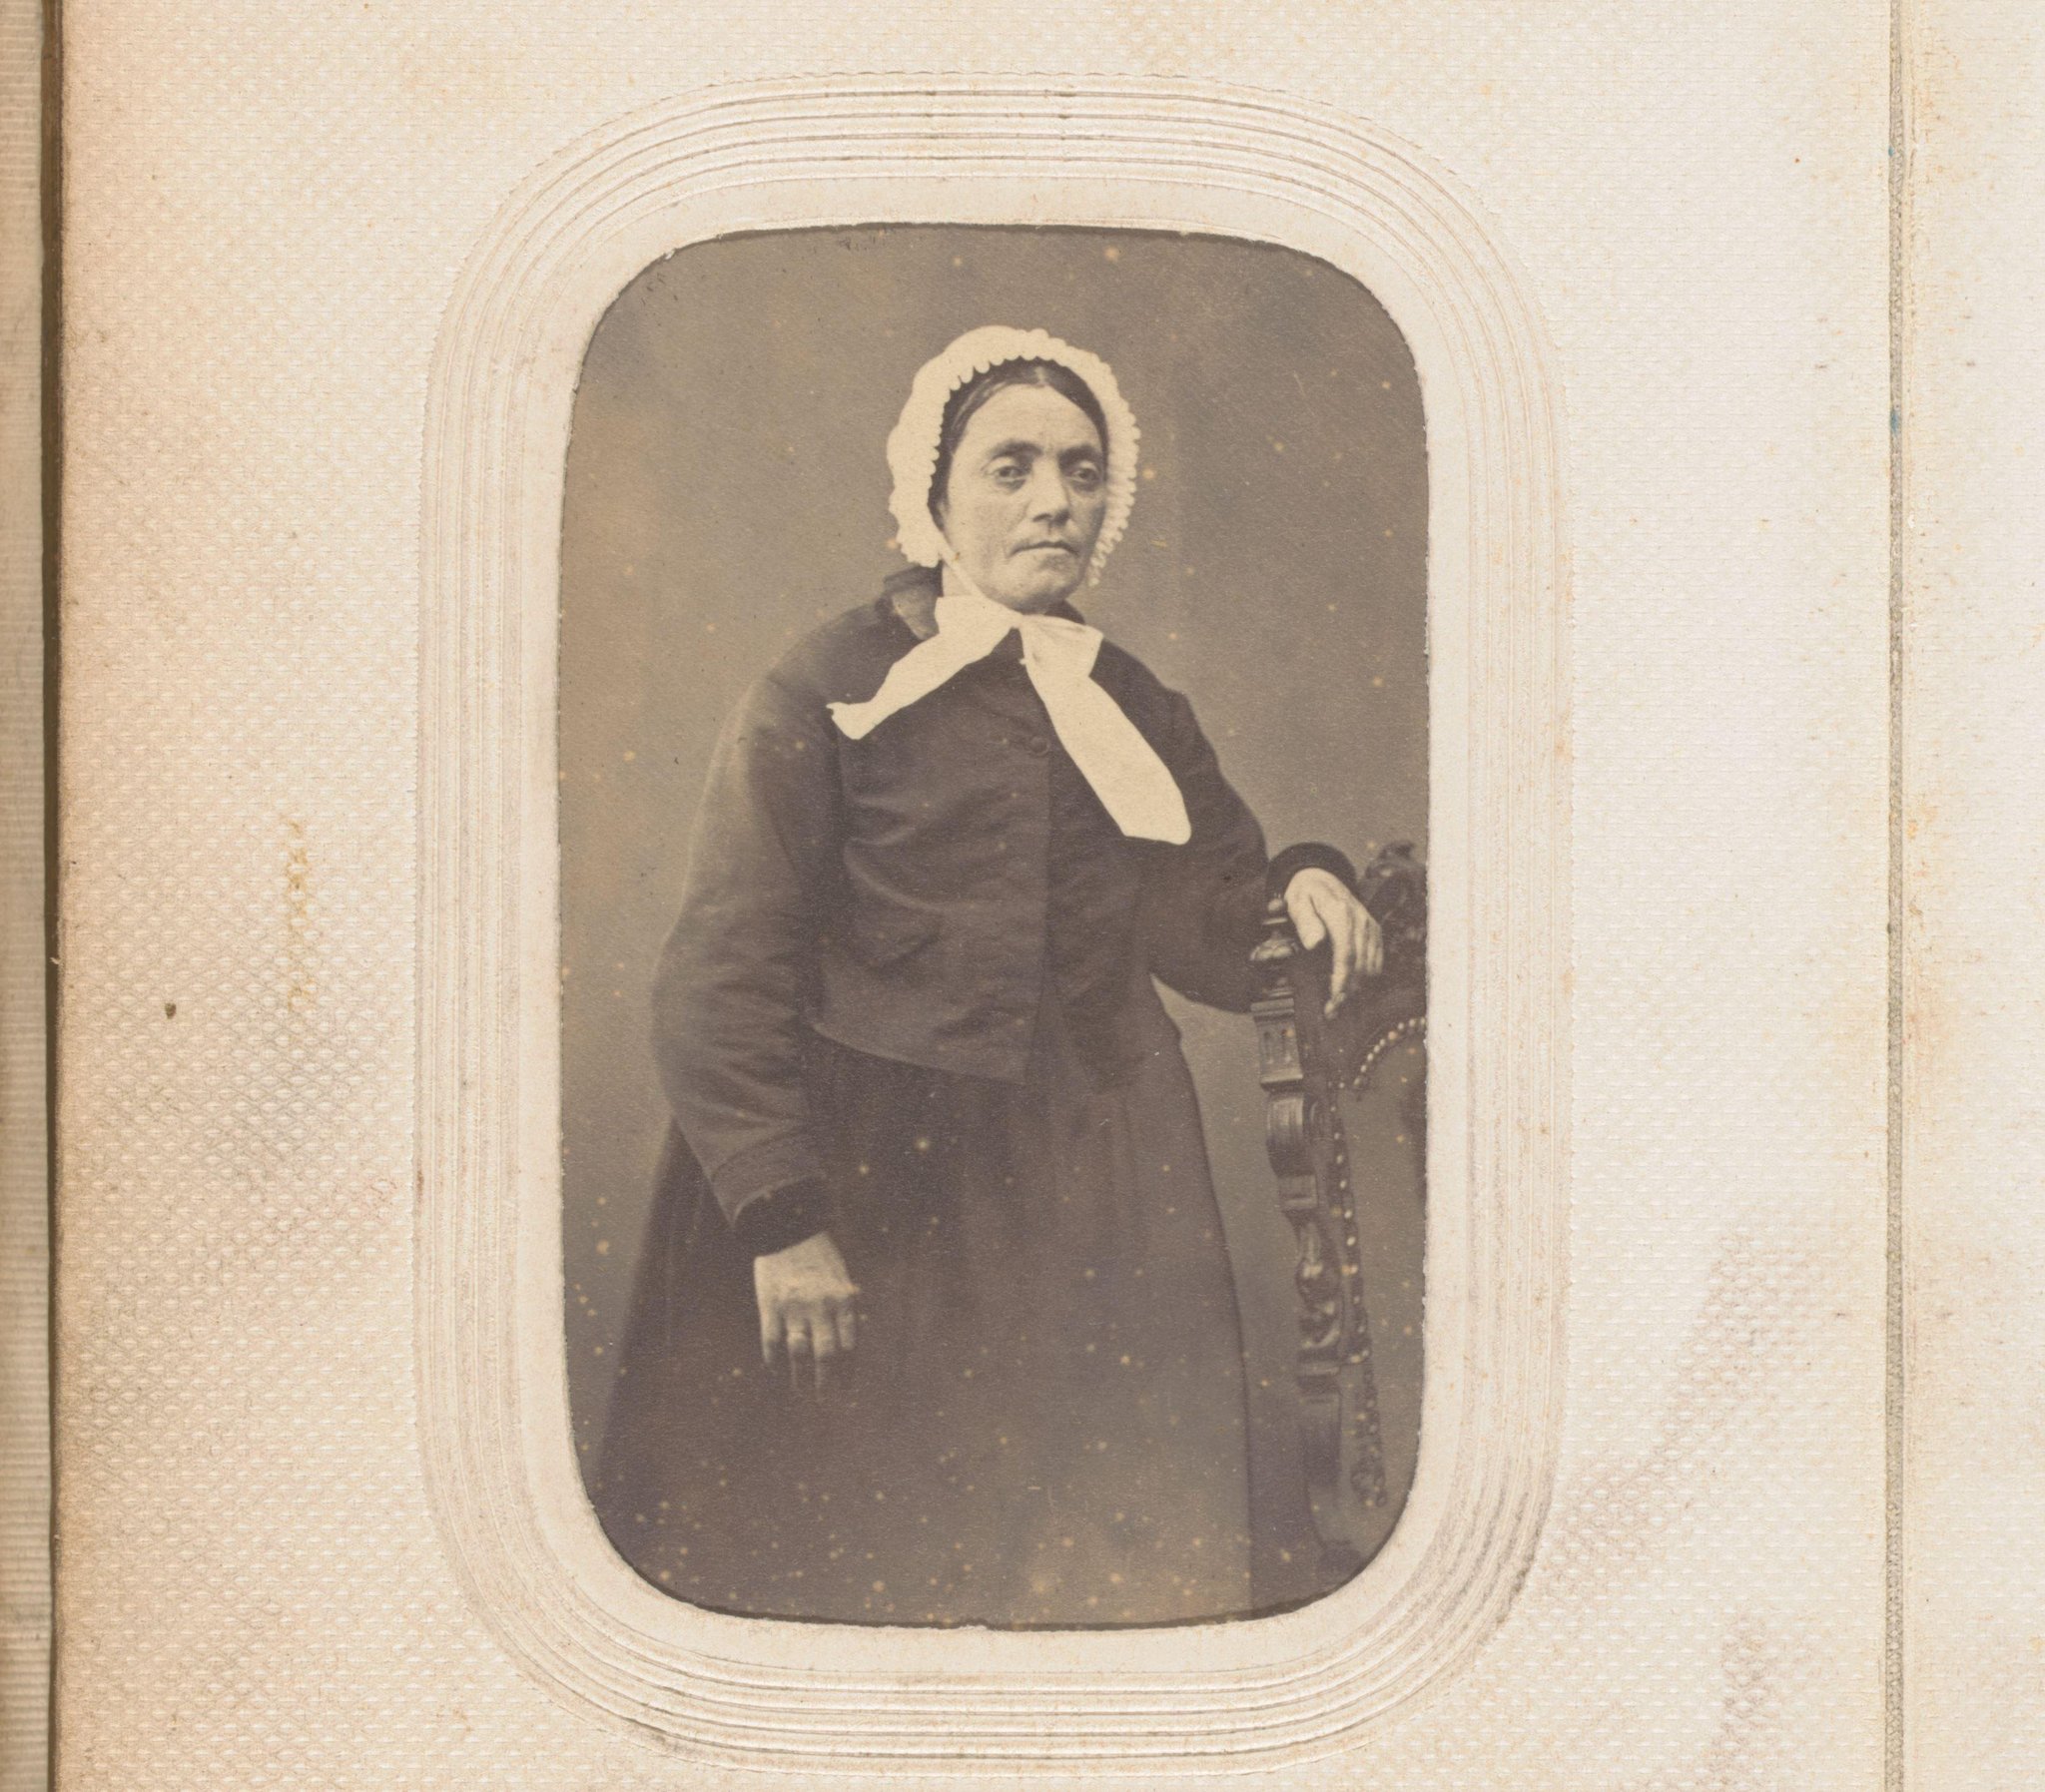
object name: album leaf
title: Portret van een staande vrouw met een witte muts met linten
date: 1860-1870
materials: cardboard, photographic support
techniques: albumen print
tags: adult woman, head-gear, historical persons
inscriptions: inscription: ‘2 Cours du XXX Juillet, Bourdeaux’